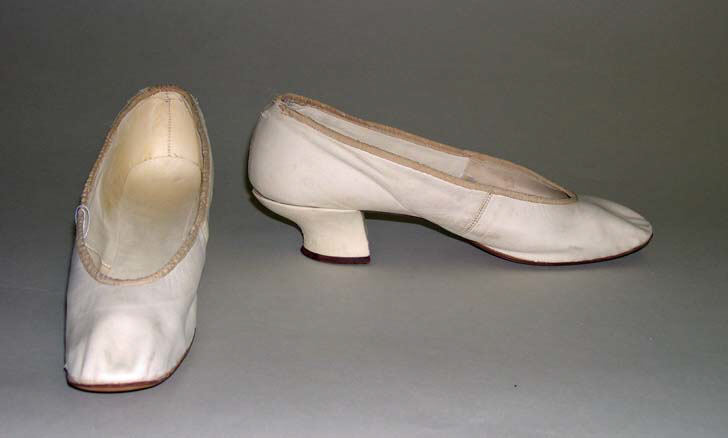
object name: slipper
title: Slippers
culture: american or european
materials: leather